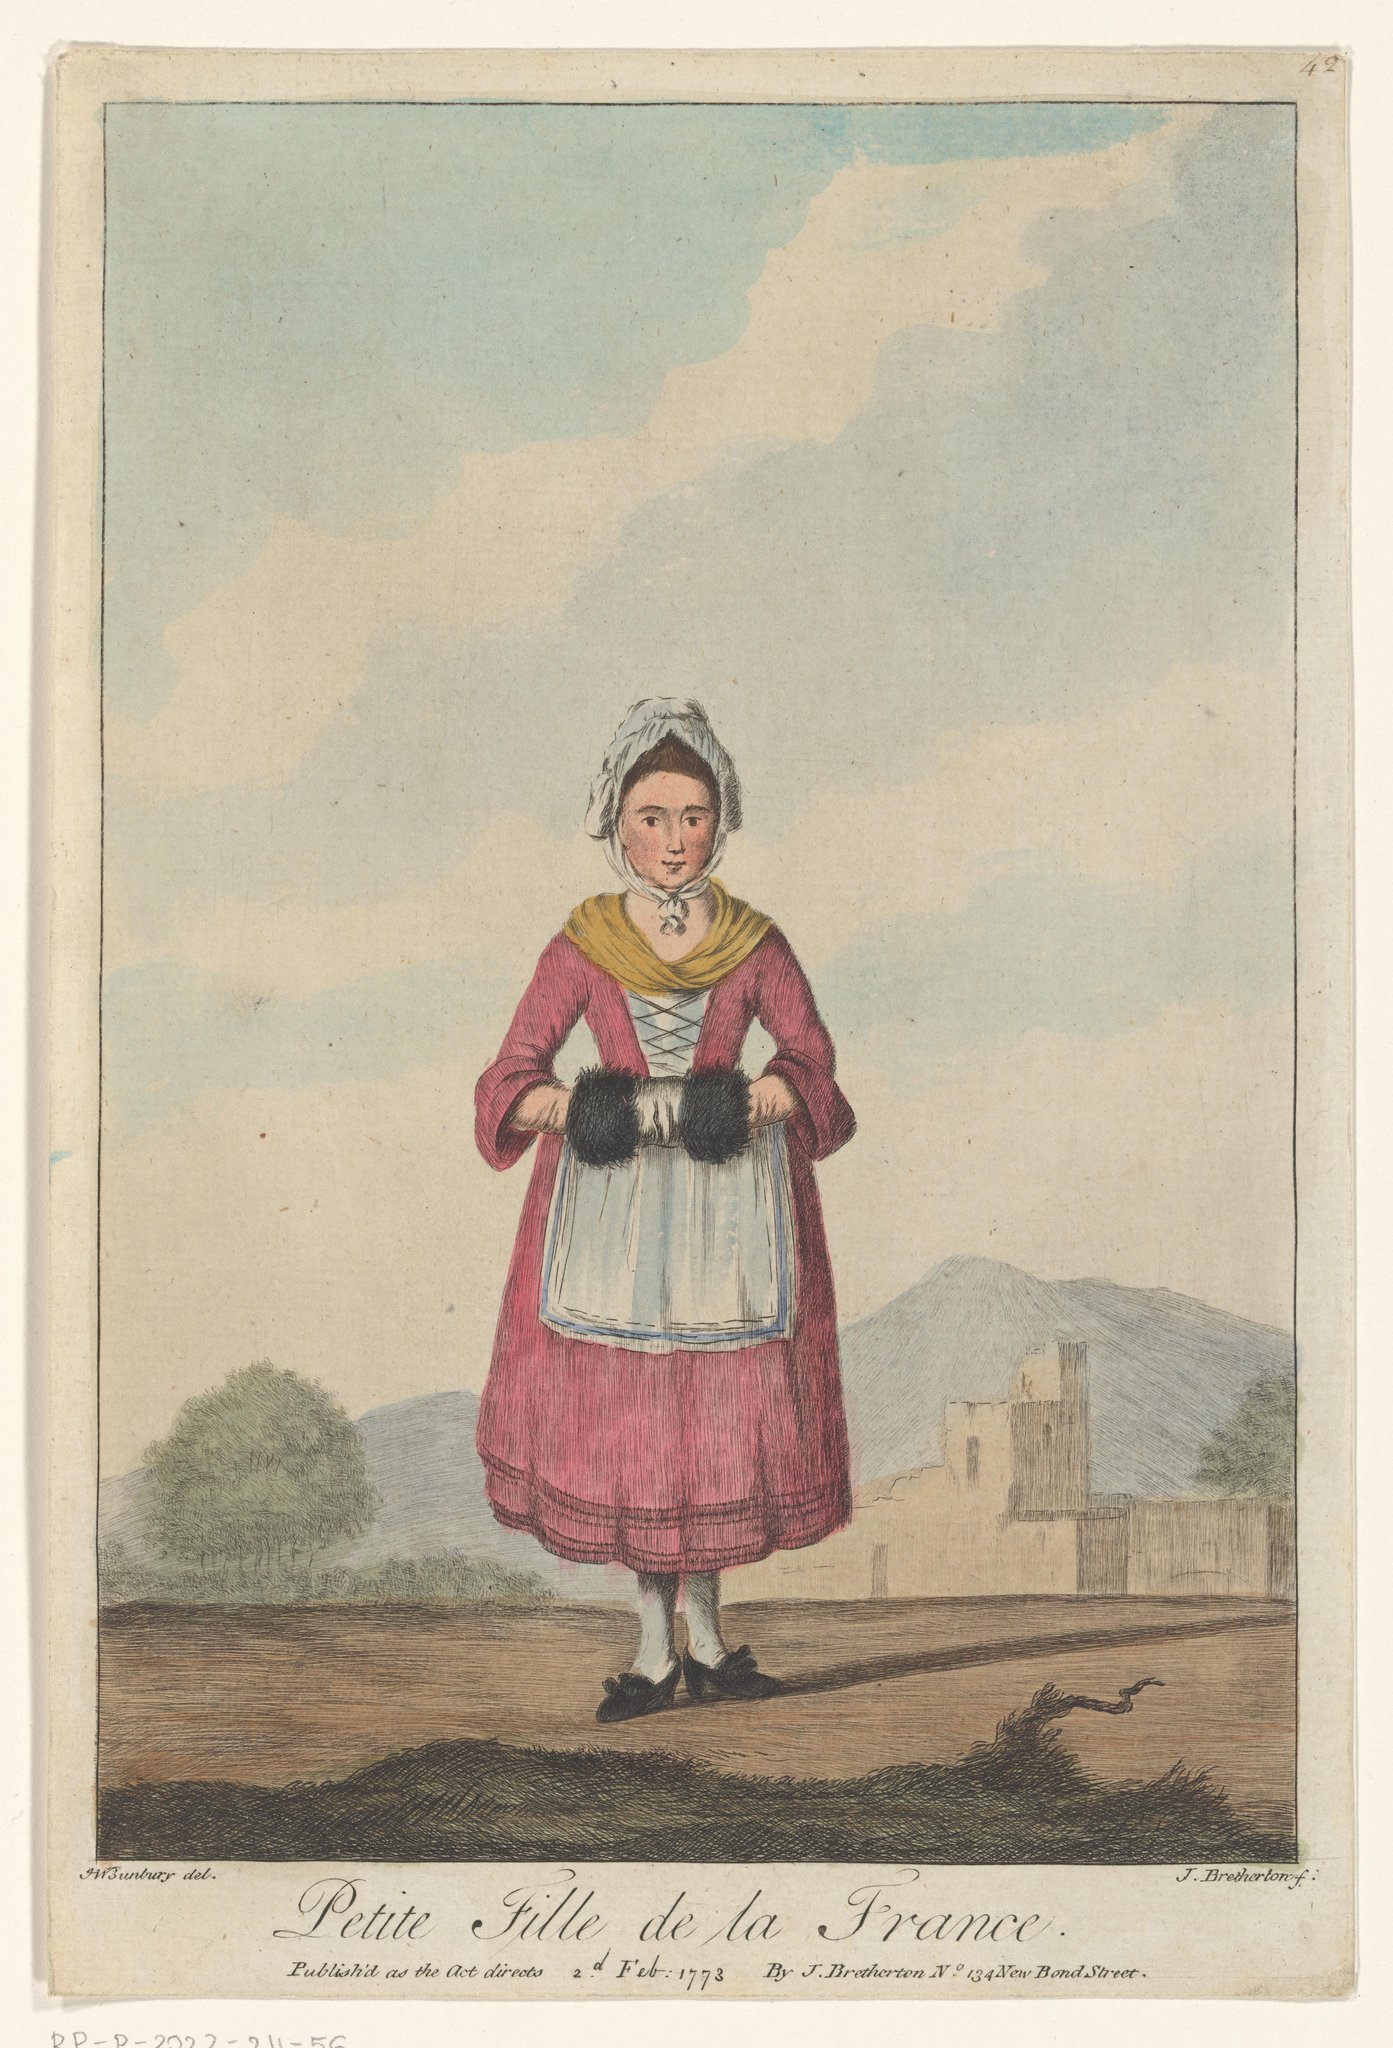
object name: print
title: Een Frans meisje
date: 1773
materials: paper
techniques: etching, hand coloring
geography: london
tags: europeans (with name) (+ costume), muff, folk costume, regional costume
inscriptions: collector's mark: Lugt 2228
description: Een Frans meisje, staand in een veld, haar handen in een mof.